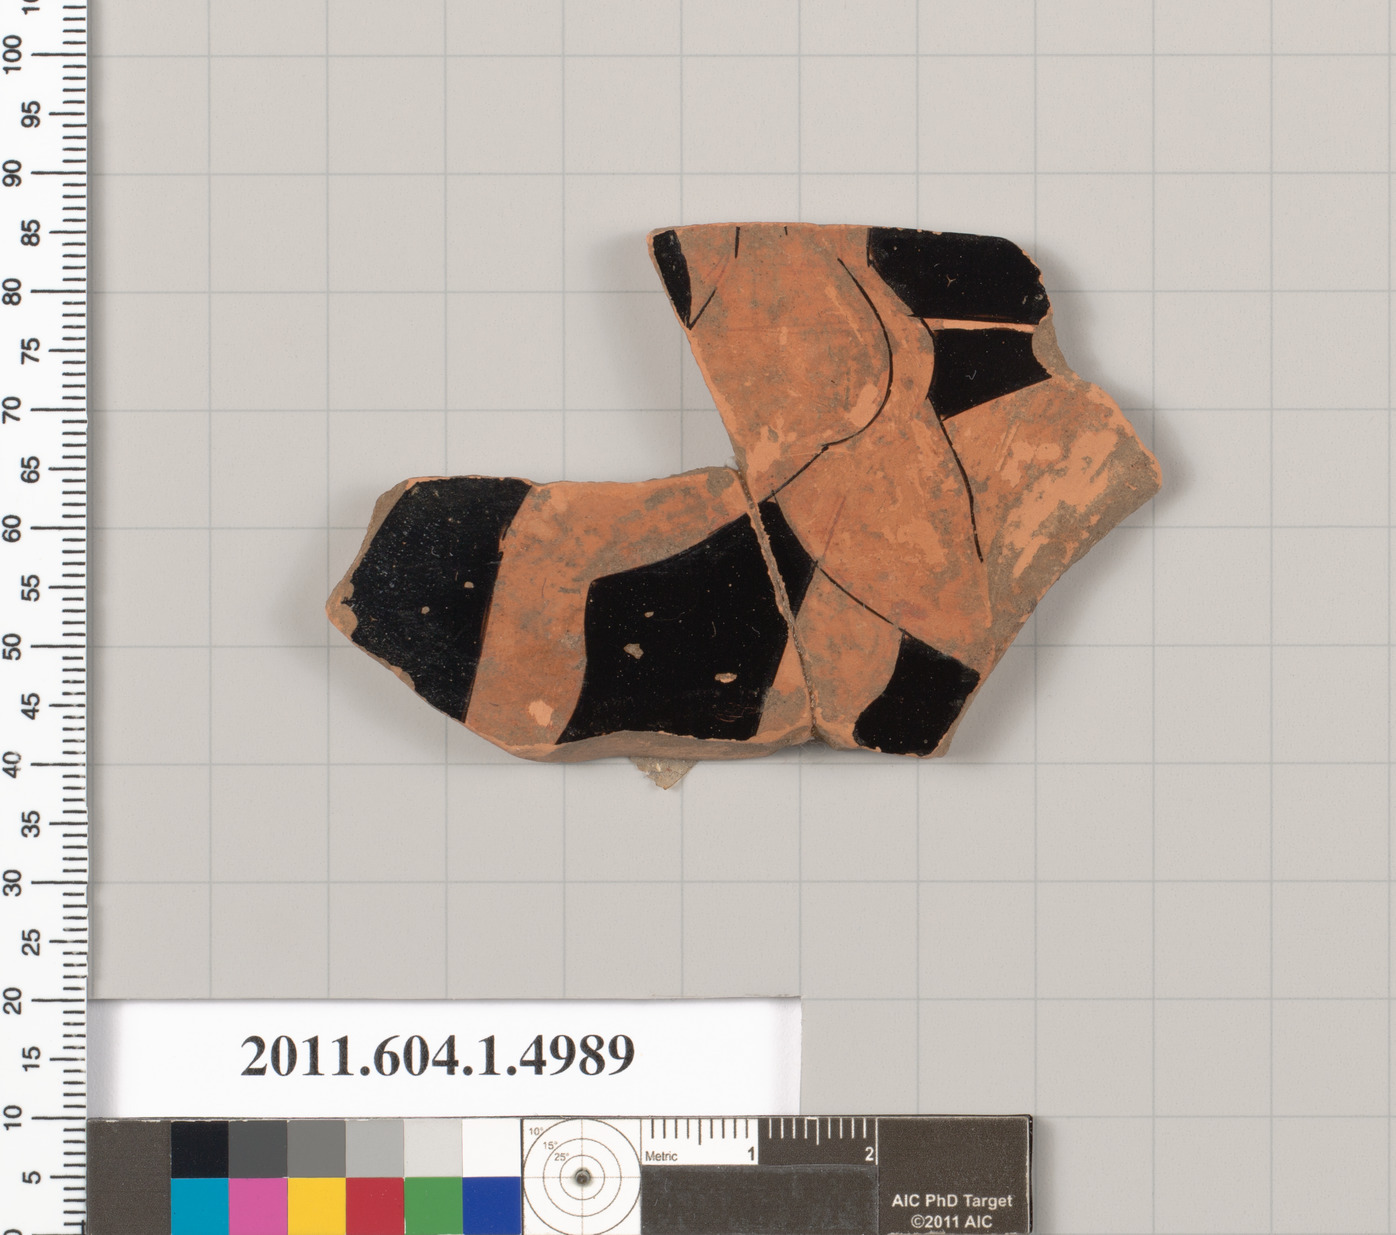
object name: kylix fragment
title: Terracotta fragment of a kylix (drinking cup)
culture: greek, attic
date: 510-490 BCE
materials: terracotta